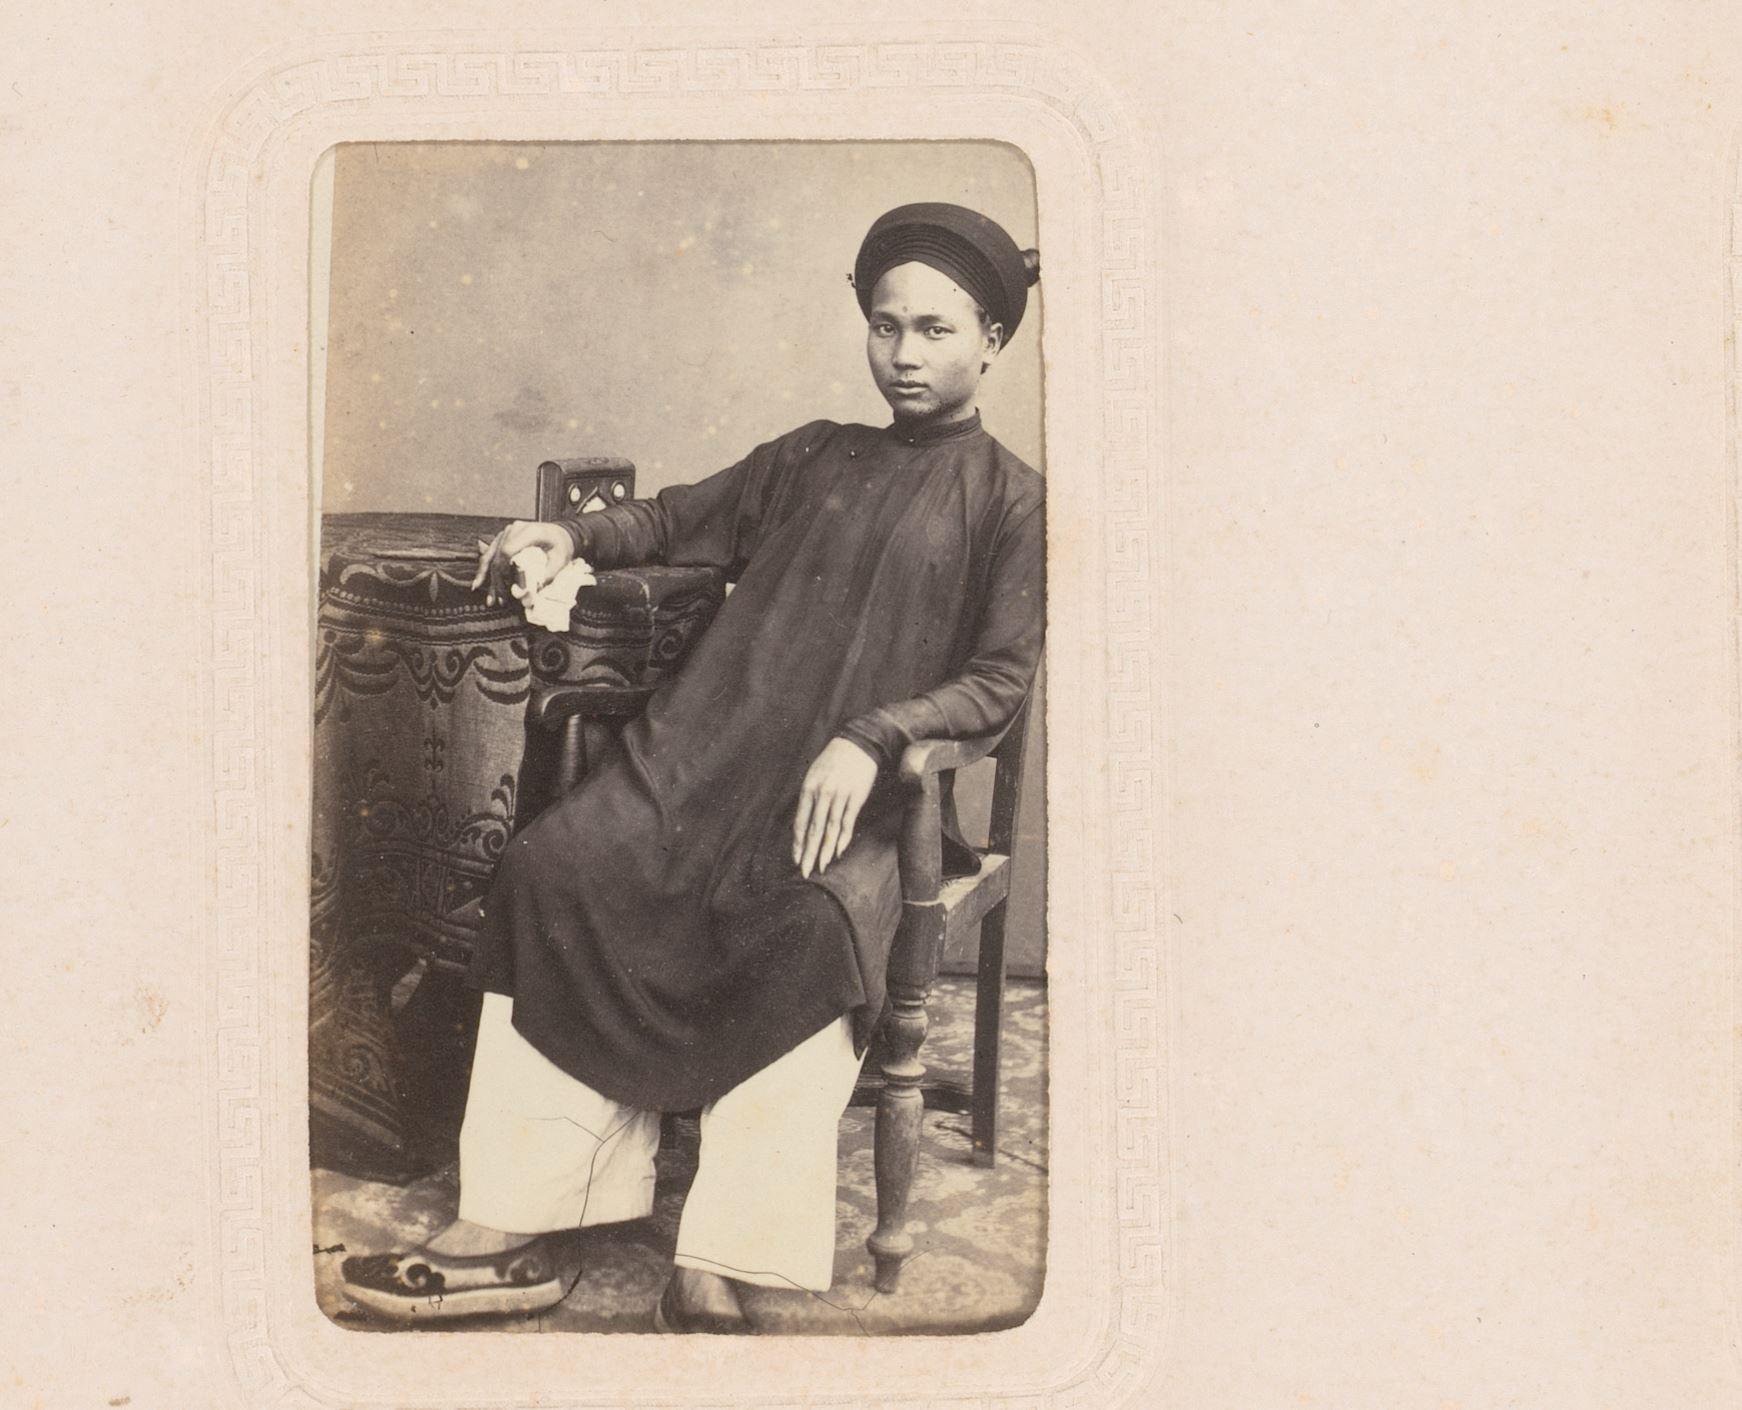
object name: photograph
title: Portret van een Vietnamese man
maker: Anonymous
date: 1850-1880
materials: cardboard, photographic support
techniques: albumen print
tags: historical persons - bb - woman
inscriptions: annotation: ‘1 Annamiet von Saigon’, number: ‘51’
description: Deze foto maakt deel uit van een album. De man draagt een ao khach (tuniek).